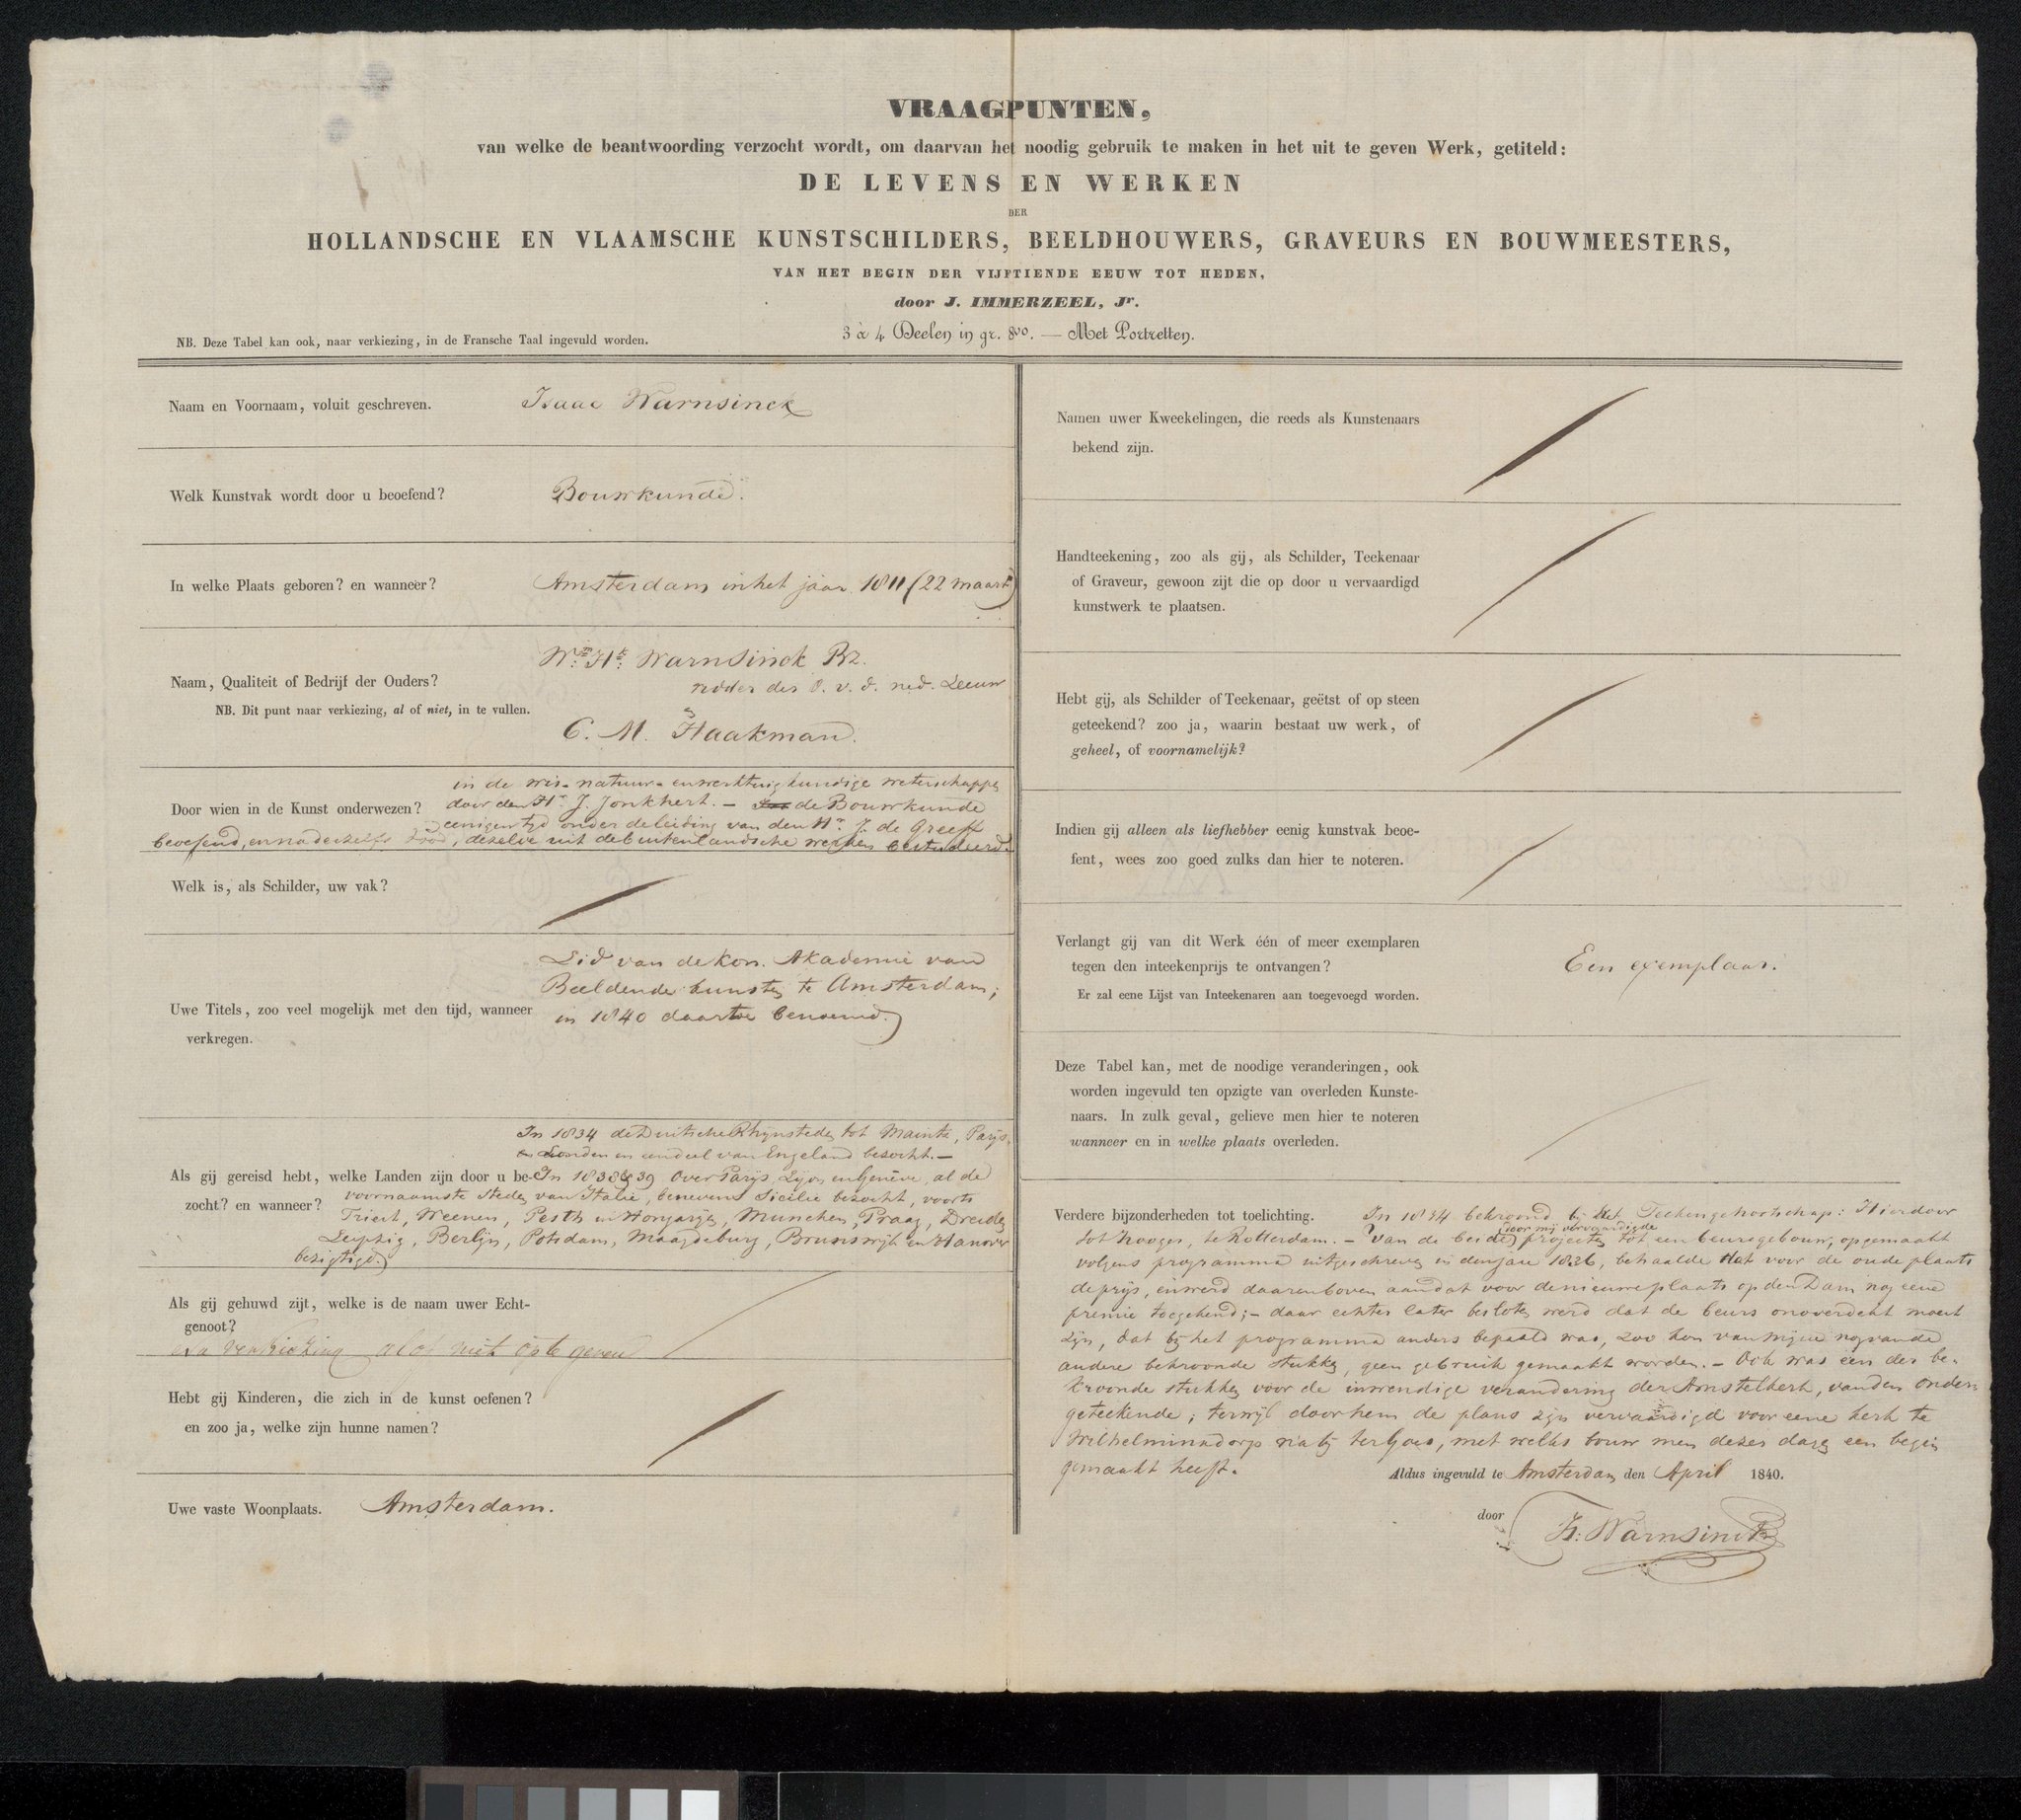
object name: manuscript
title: Enquêteformulier ingevuld door Isaac Warnsinck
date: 1804-1840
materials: ink, paper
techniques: pen, printing, writing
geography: amsterdam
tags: amsterdam, isaac warnsinck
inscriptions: watermark, inscription: ‘Vraagpunten,/ van welke de beantwoording verzocht wordt, om daarvan het noodig gebruik te maken in het uit te geven Werk, getiteld: De levens en werken/ der Hollandsche en Vlaamsche kunstschilders, beeldhouwers,/ graveurs en bouwmeesters, van het begin der vijftiende eeuw tot heden/ door J. Immerzeel, Jr.’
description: Opgenomen in: Immerzeel, J. Jr., De levens en werken der Hollandsche en Vlaamsche kunstschilders, beeldhouwers, graveurs en bouwmeesters, van het begin der vijftiende eeuw tot heden, Amsterdam: J.C. van Kesteren, 1842-1843.